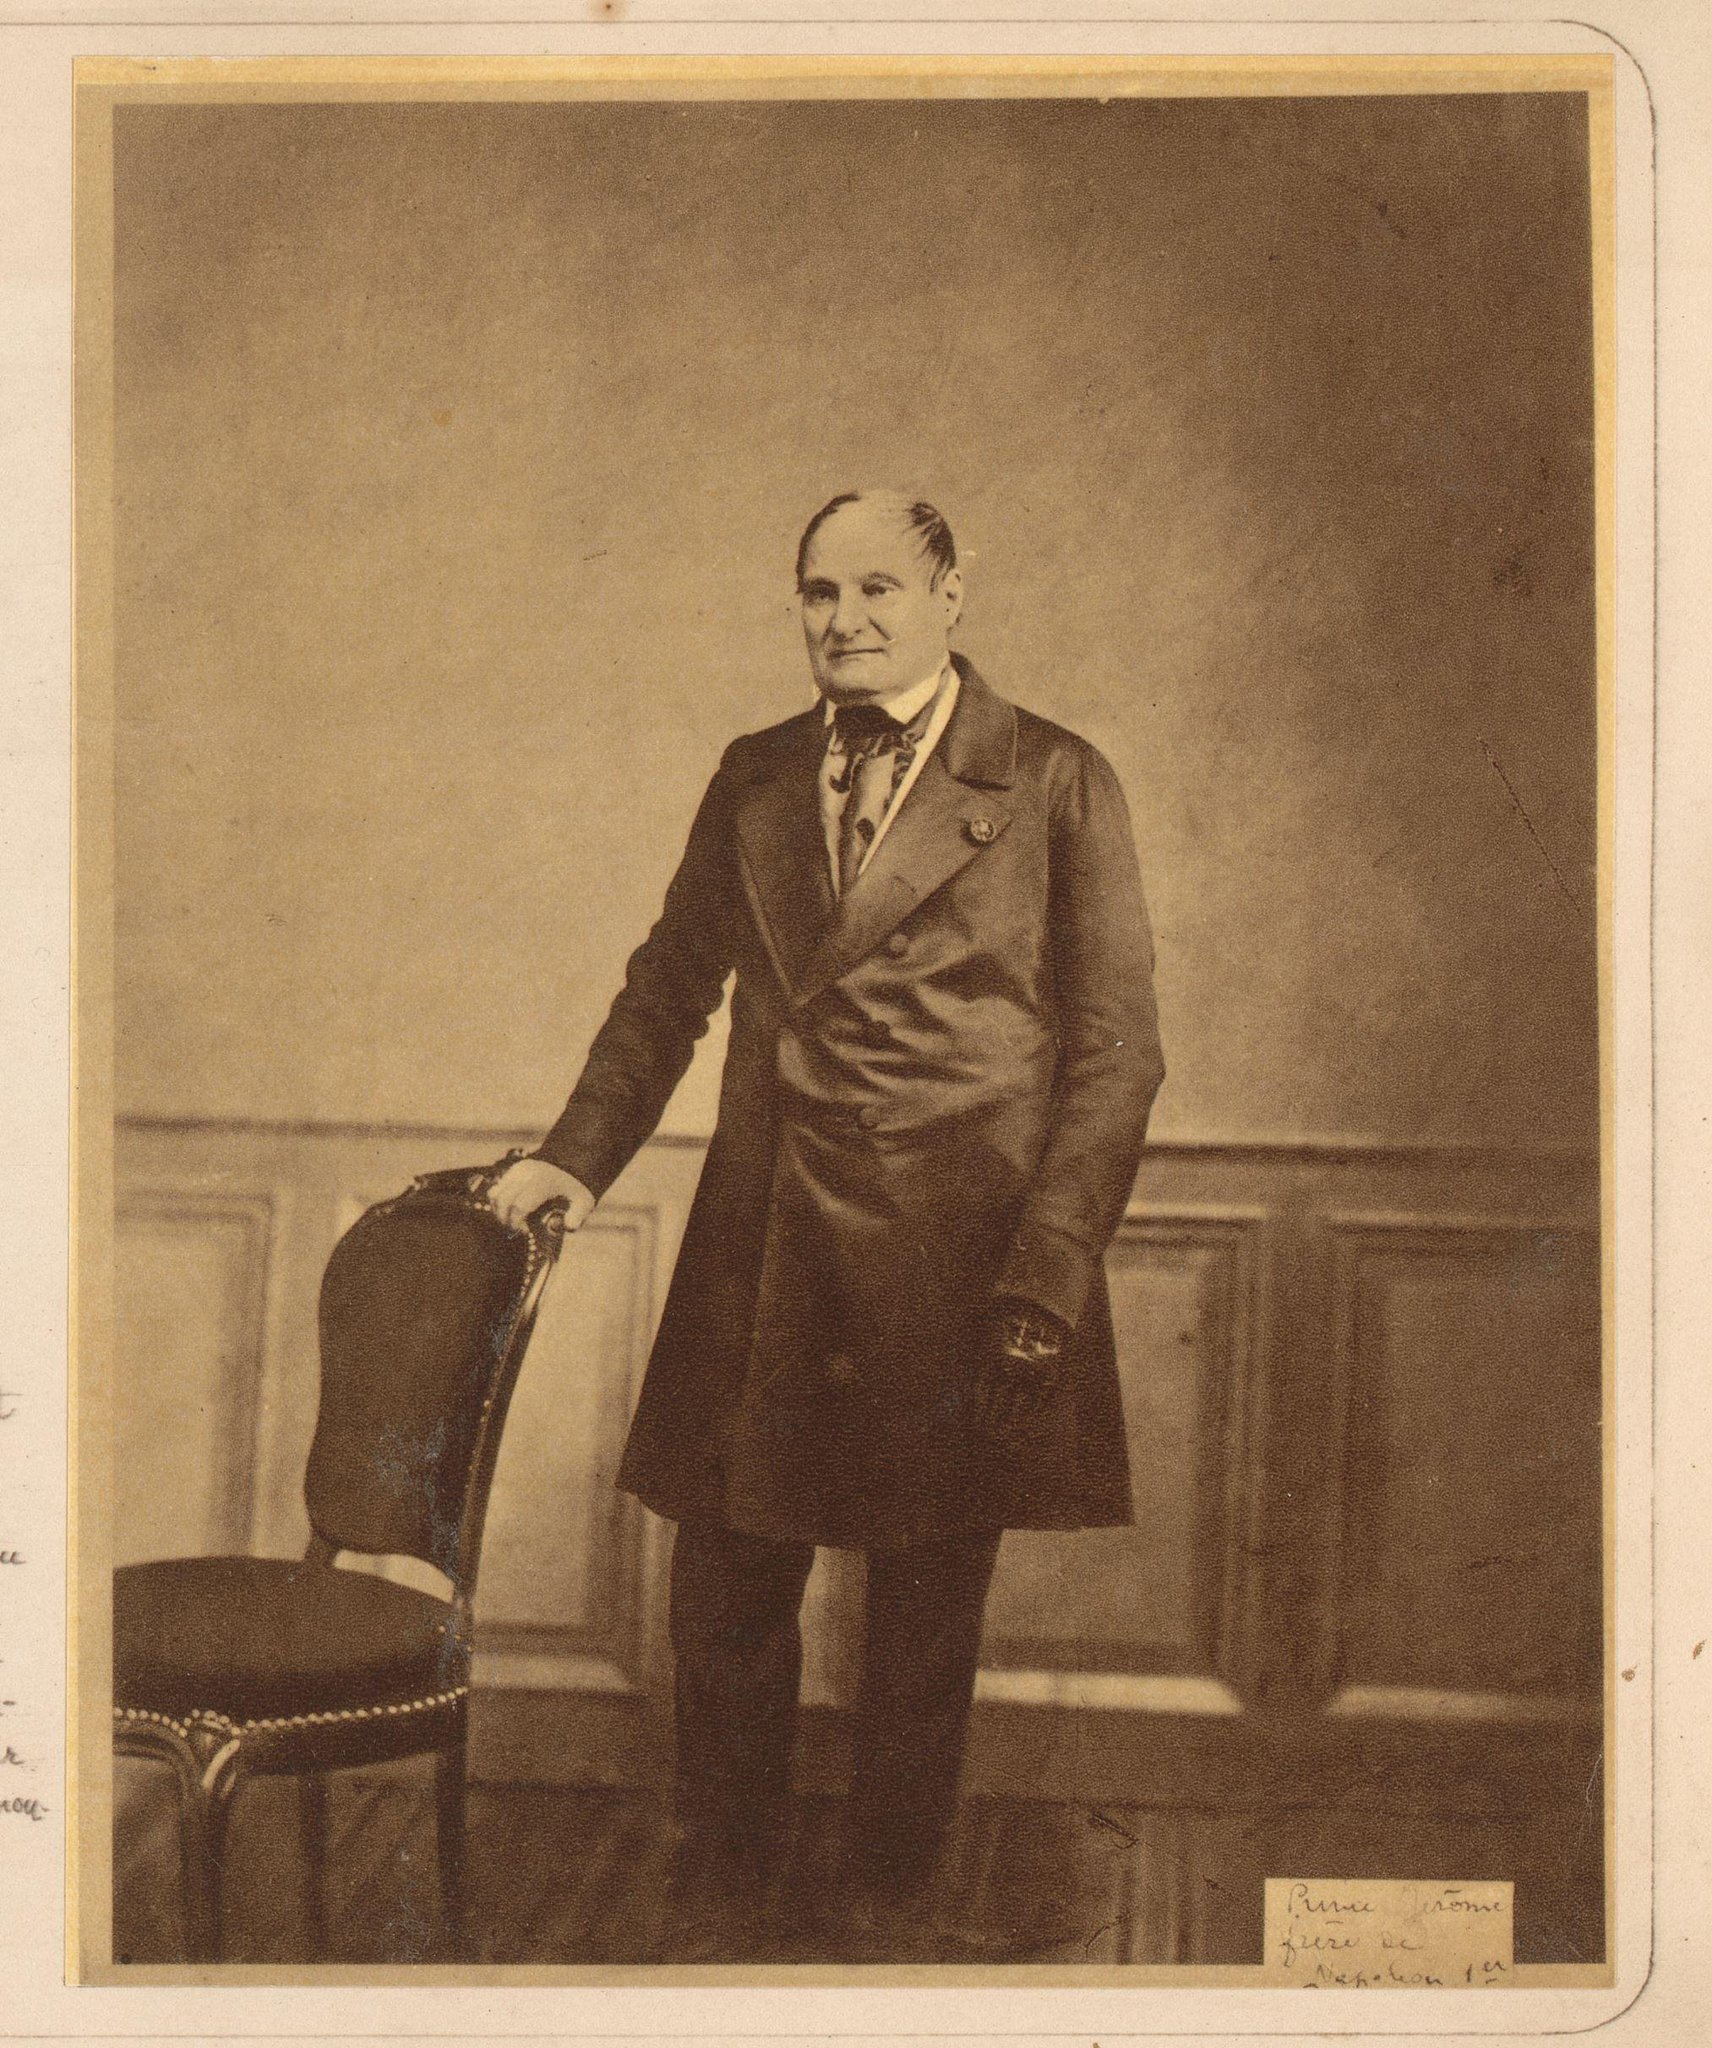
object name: album leaf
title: Portret van Jérôme Bonaparte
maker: Anonymous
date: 1858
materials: paper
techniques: rotogravure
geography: france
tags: paris, historical persons, king, france